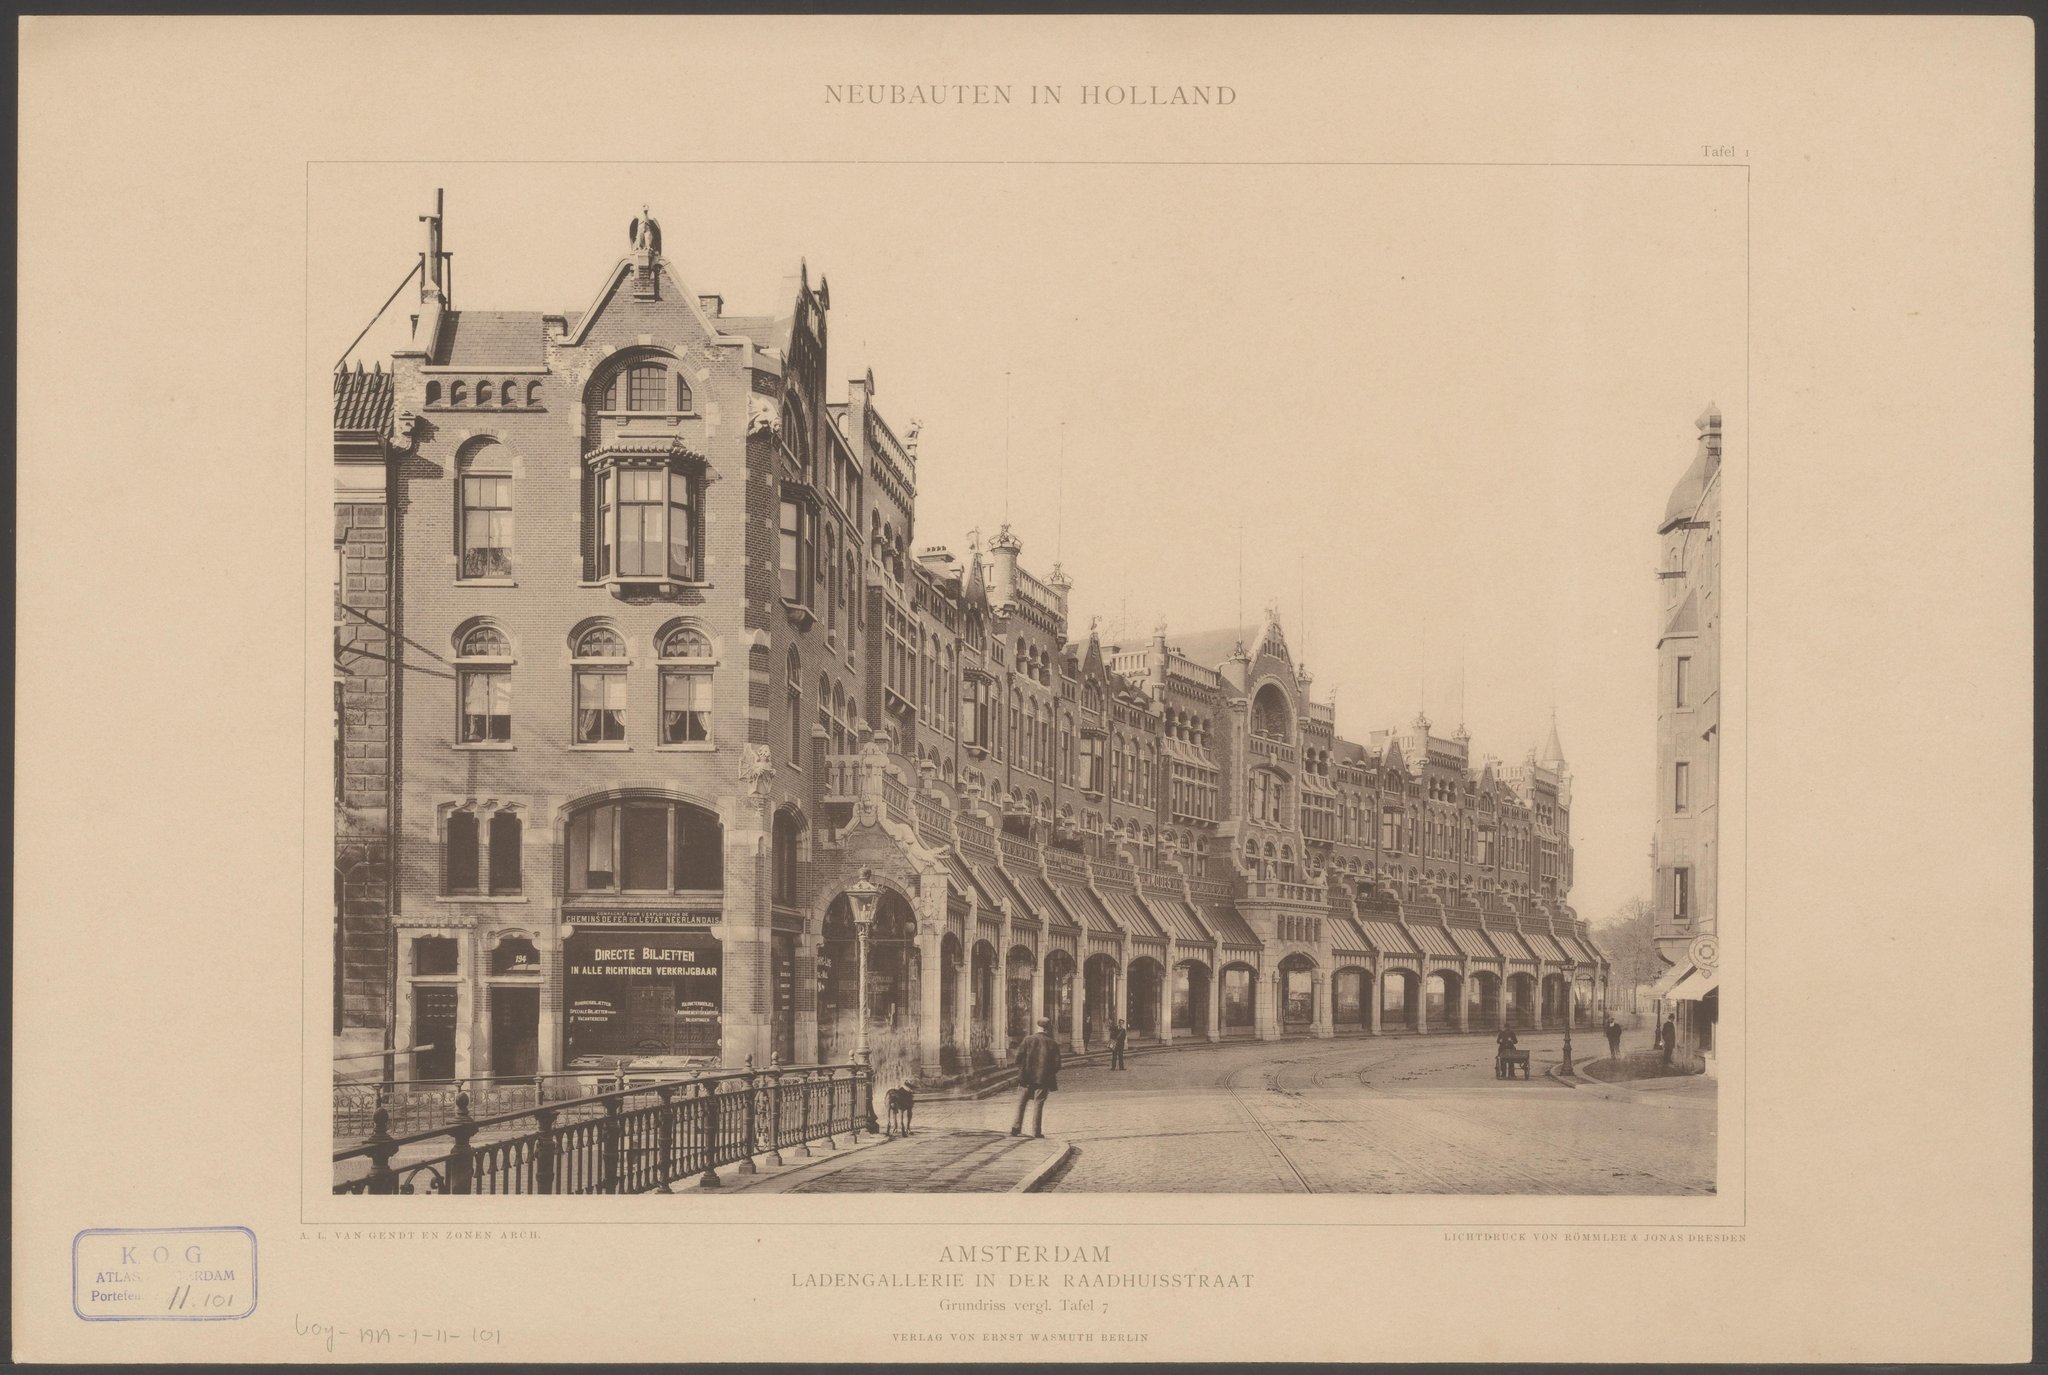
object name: photomechanical print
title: Neubauten in Holland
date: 1899-1945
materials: cardboard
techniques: photograph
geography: amsterdam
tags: city-view in general; 'veduta', gallery (spacious corridor), façade (of house or building), street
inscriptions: collector's mark: ‘11.101’ Lugt 1641b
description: Onderwerpsrubriek binnen de Atlas Amsterdam: Raadhuisstraat, Raamgracht, Raamplein, Rapenburgerstraat, Reguliersgracht, Reguliersbreestraat.